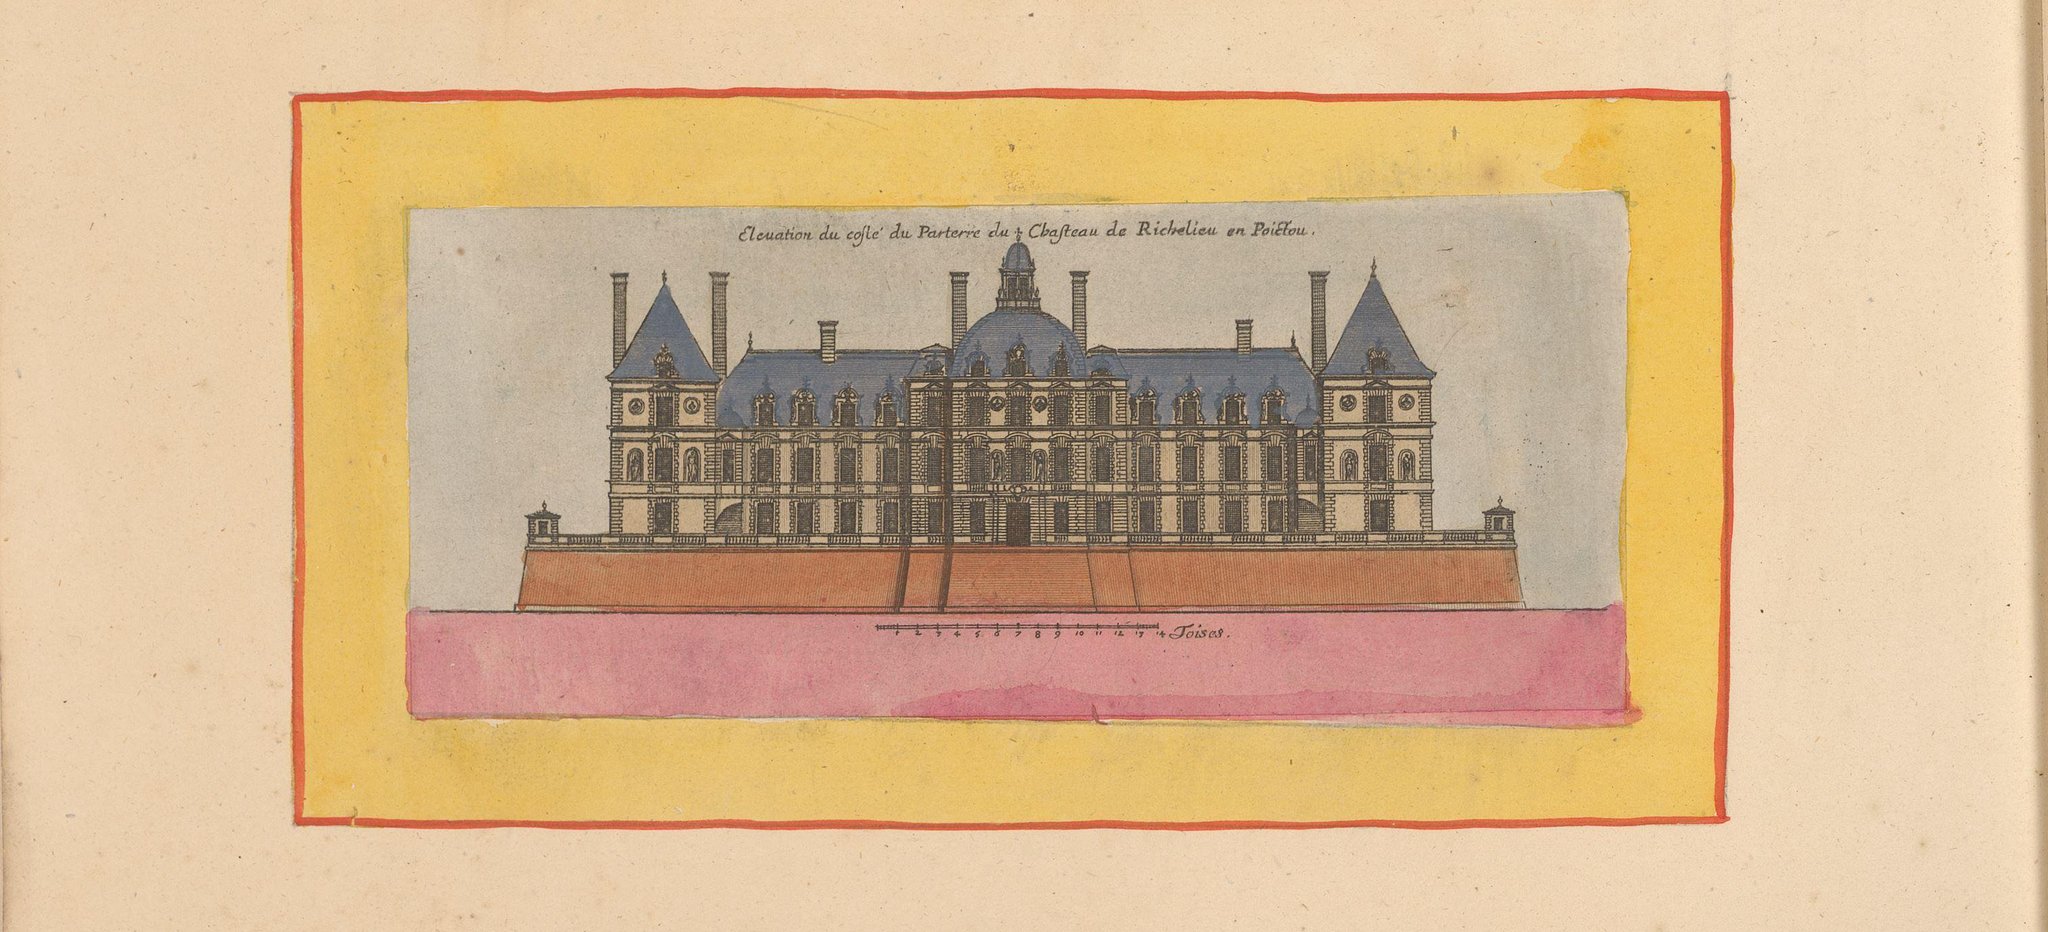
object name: print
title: Le magnifique chasteau de Richelieu, ou les plans, les fassades, les elevations et profils du dit chasteau (...)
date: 1629-1679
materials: paper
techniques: etching, hand coloring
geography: the hague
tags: castle, series of designs, models, etc. of one architectural project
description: Deze prent maakt deel uit van een album.